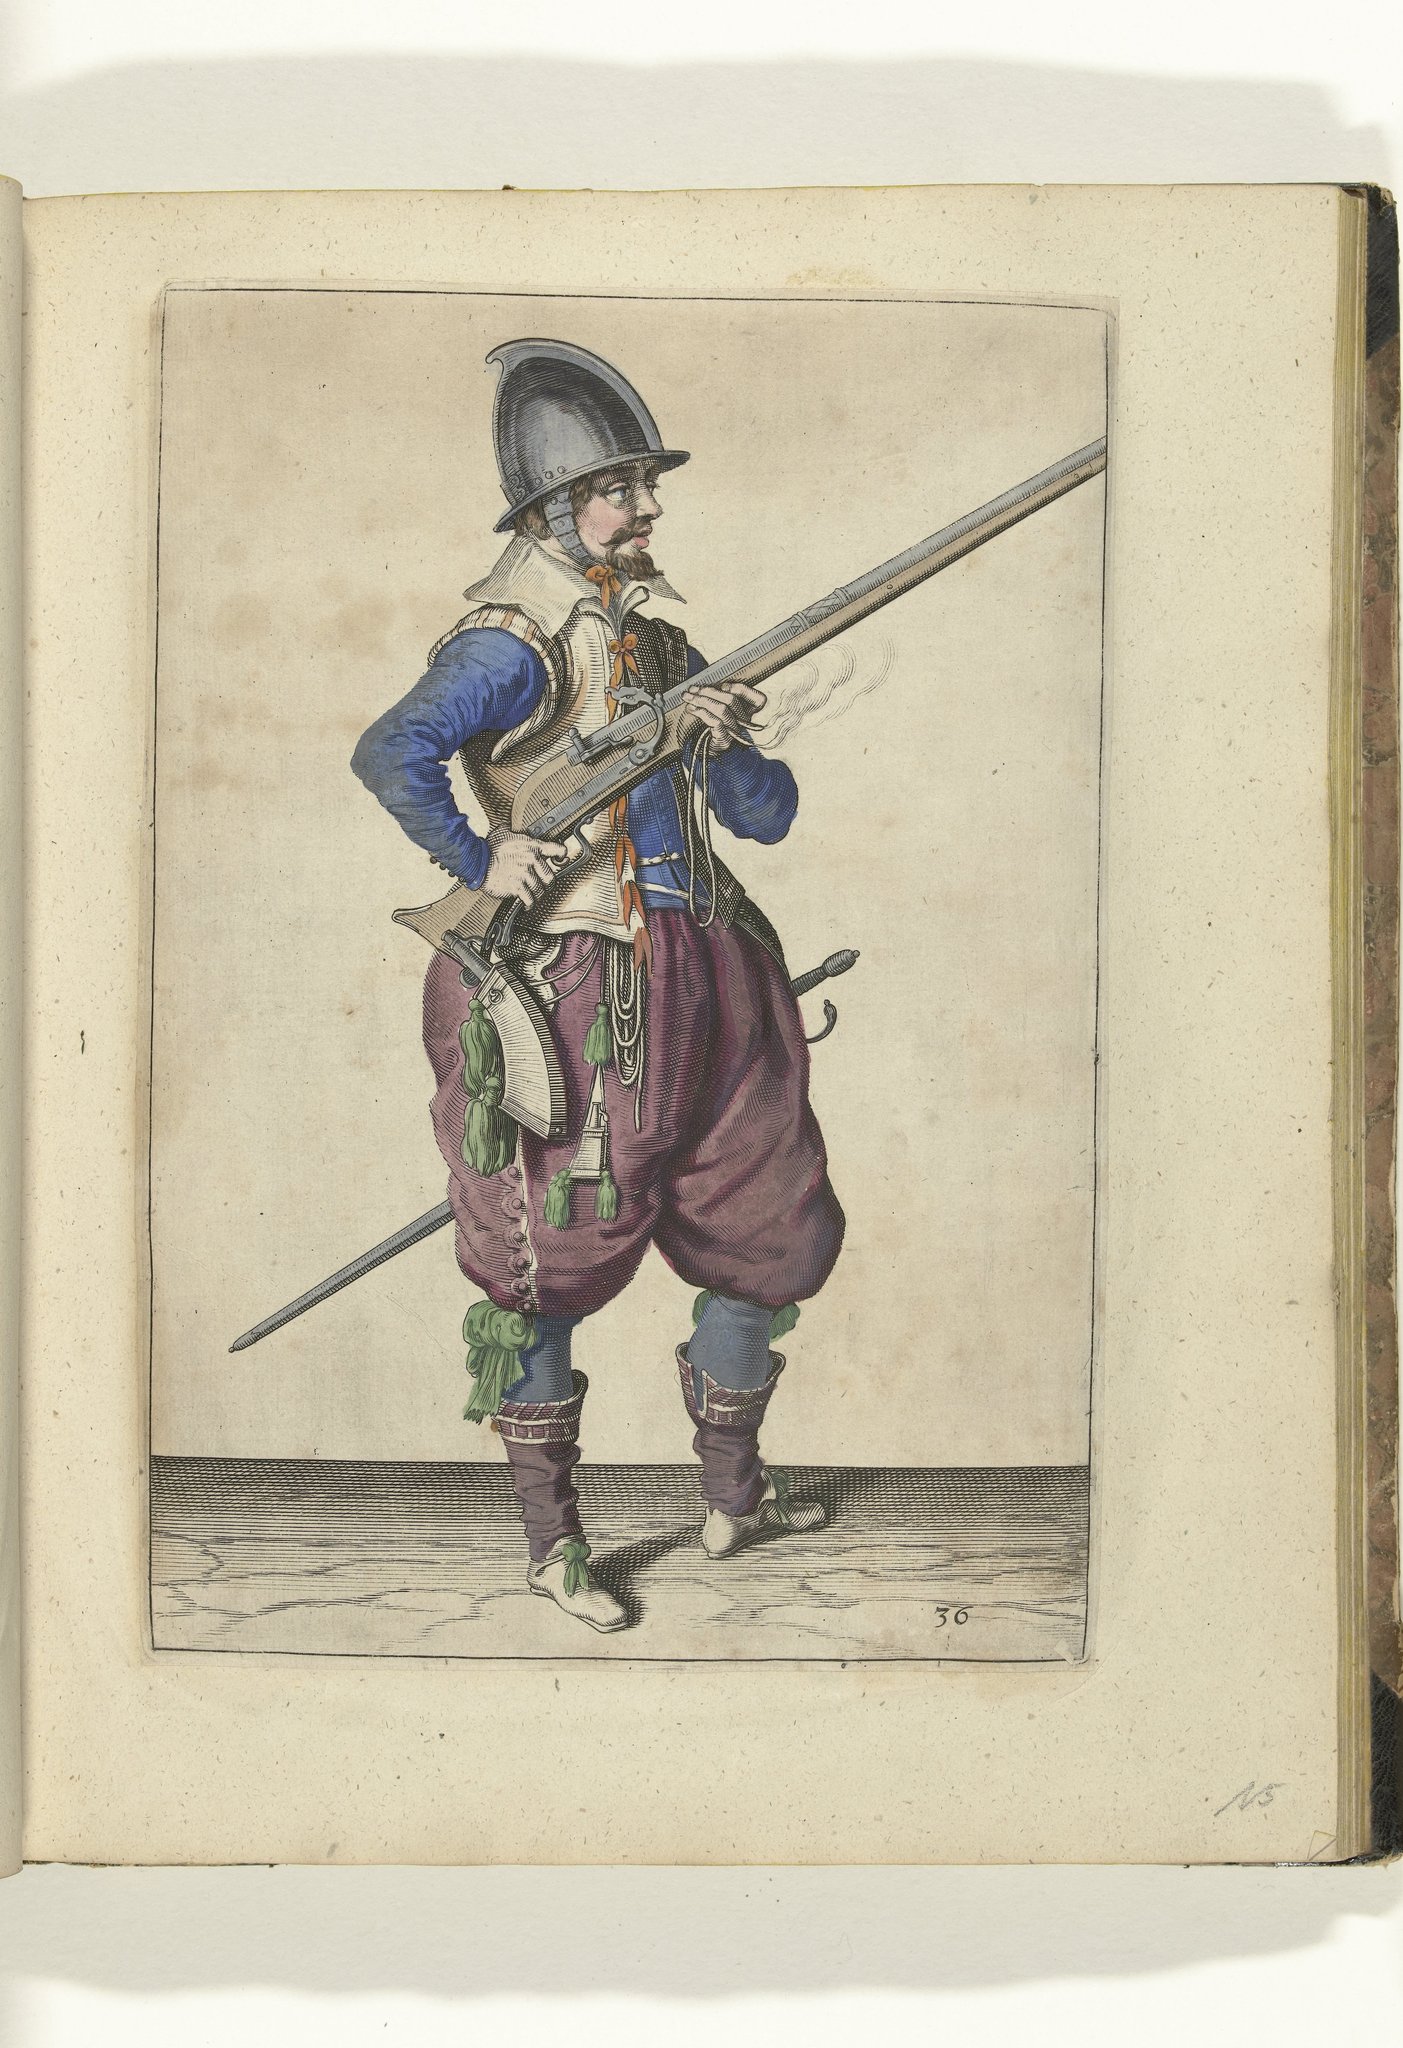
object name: print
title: Soldaat op wacht die zijn roer bij zijn rechterzijde schuin omhoog gericht vasthoudt, zijn vinger aan de trekker (nr. 36), ca. 1600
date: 1597-1608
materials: paper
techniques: engraving, hand coloring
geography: northern netherlands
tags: maurice (prince of orange), handling of weapons ~ military training, weapons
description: Een soldaat op wacht, ten voeten uit, naar rechts, die een roer (een bepaald type vuurwapen) met beide handen bij zijn rechterzijde vasthoudt, zijn rechterwijsvinger aan de trekker, de loop schuin omhoog gericht (nr. 36), ca. 1600. In zijn linkerhand behalve de loop van het roer ook een brandende lont. Plaat 36 in de instructies voor het hanteren van de roer: Shorte instruction upon the contrefaictinges, touching the right use of calivers. Onderdeel van de illustraties in een Engelse editie van J. de Gheyns Wapenhandelinghe: J. de Gheyn, The exercise of armes for calivres, muskettes and pikes after the ordre of Maurits Prince of Orange, 's-Gravenhage 1608. Krijgswezen rond 1600.